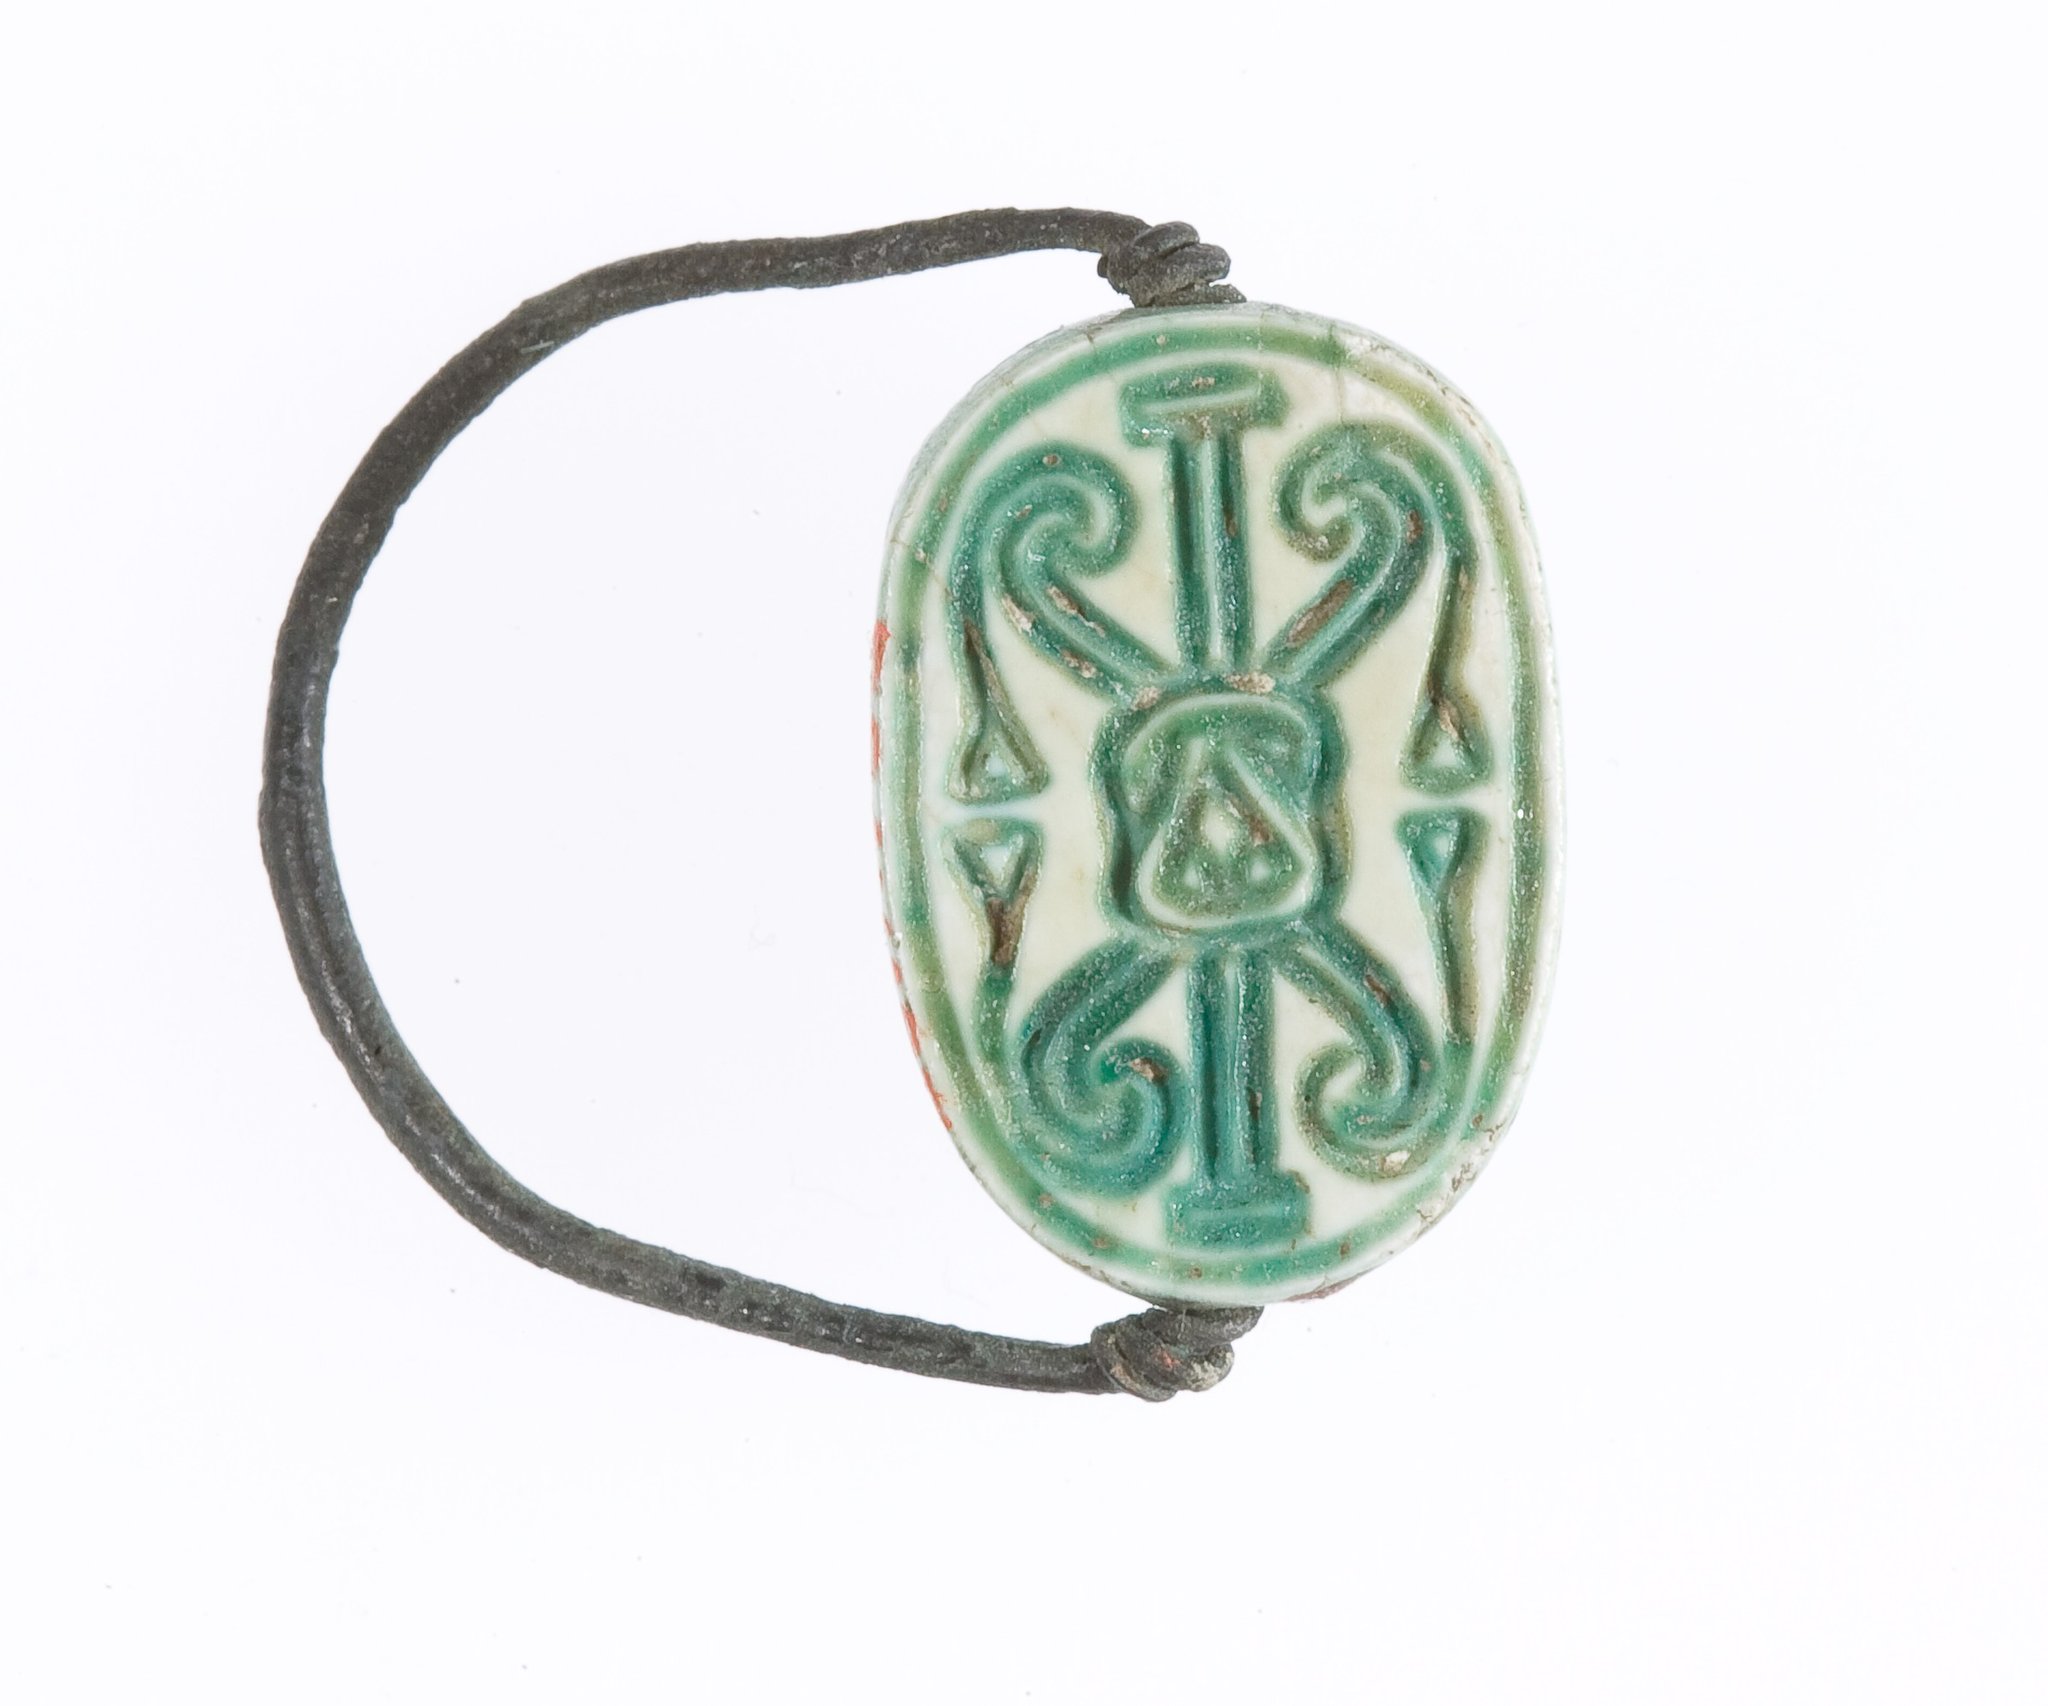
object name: ring, scarab, geometric design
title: Scarab Finger Ring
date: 1991-1450 BCE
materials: silver, stone, metal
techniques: glazing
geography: egypt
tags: scarabs